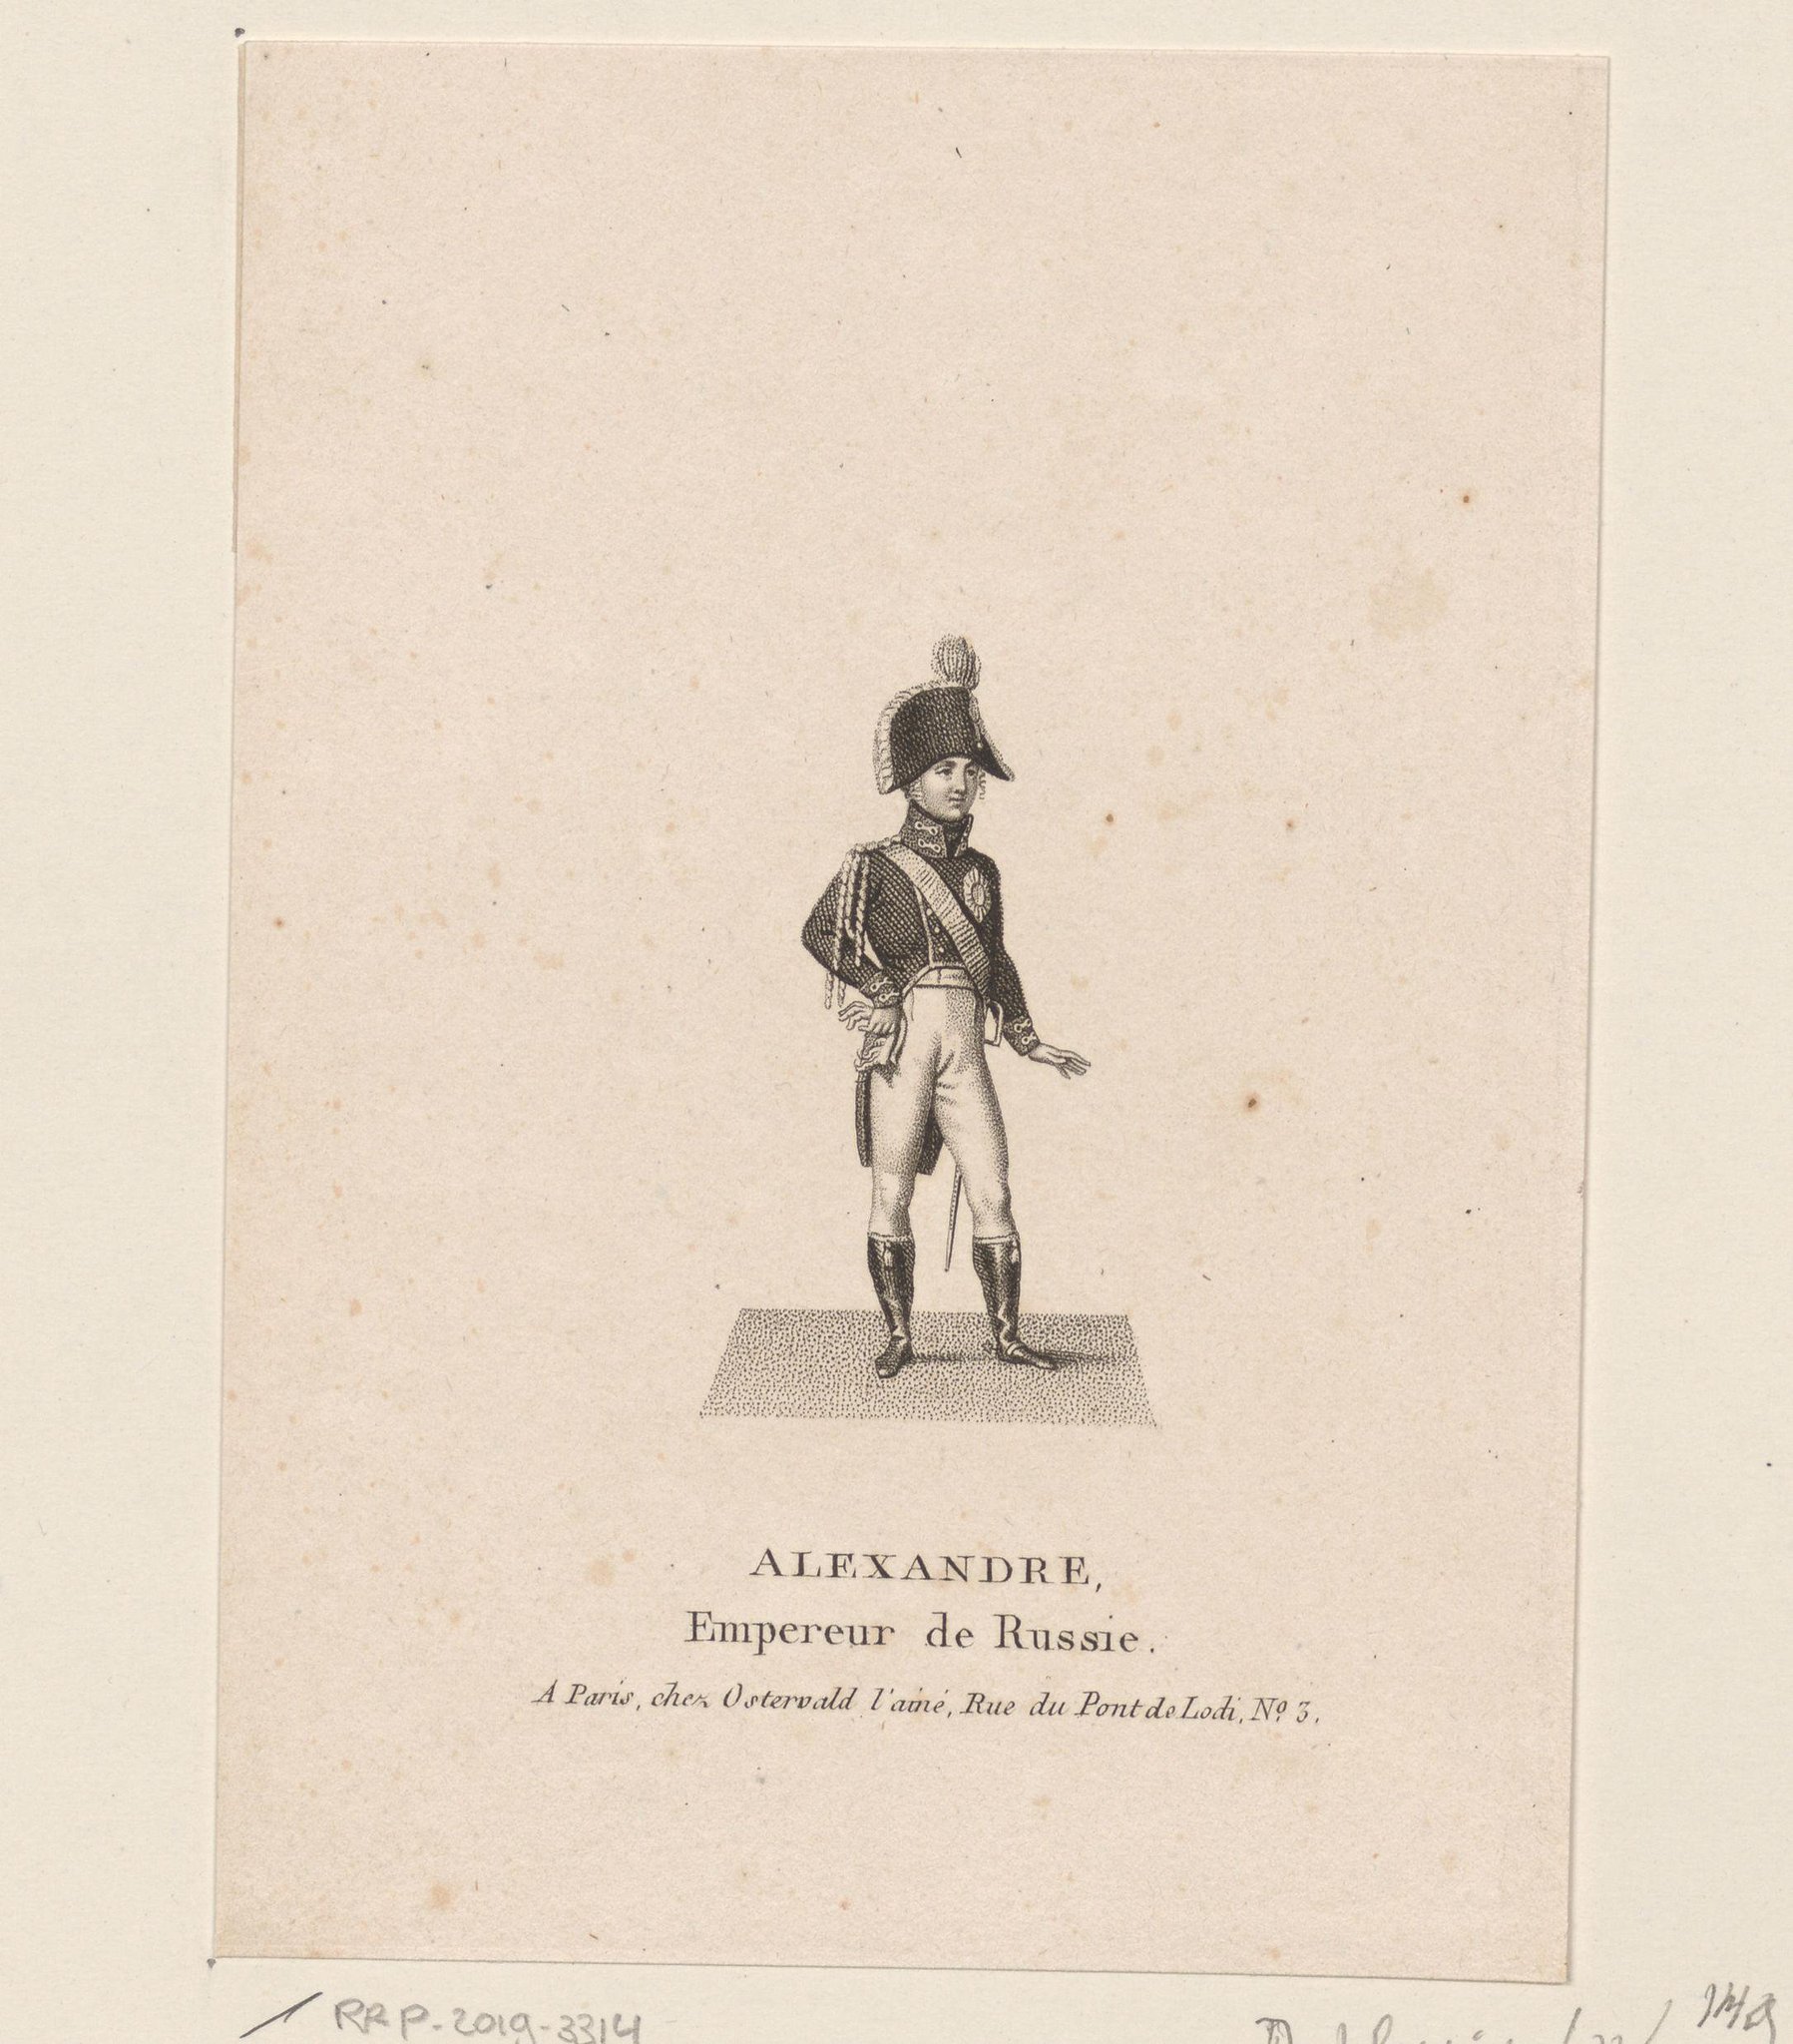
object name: print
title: Portret van Alexander I, tsaar van Rusland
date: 1817-1840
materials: paper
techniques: etching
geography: théâtre des folies-marigny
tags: alexander i (tsaar van rusland), historical persons, emperor